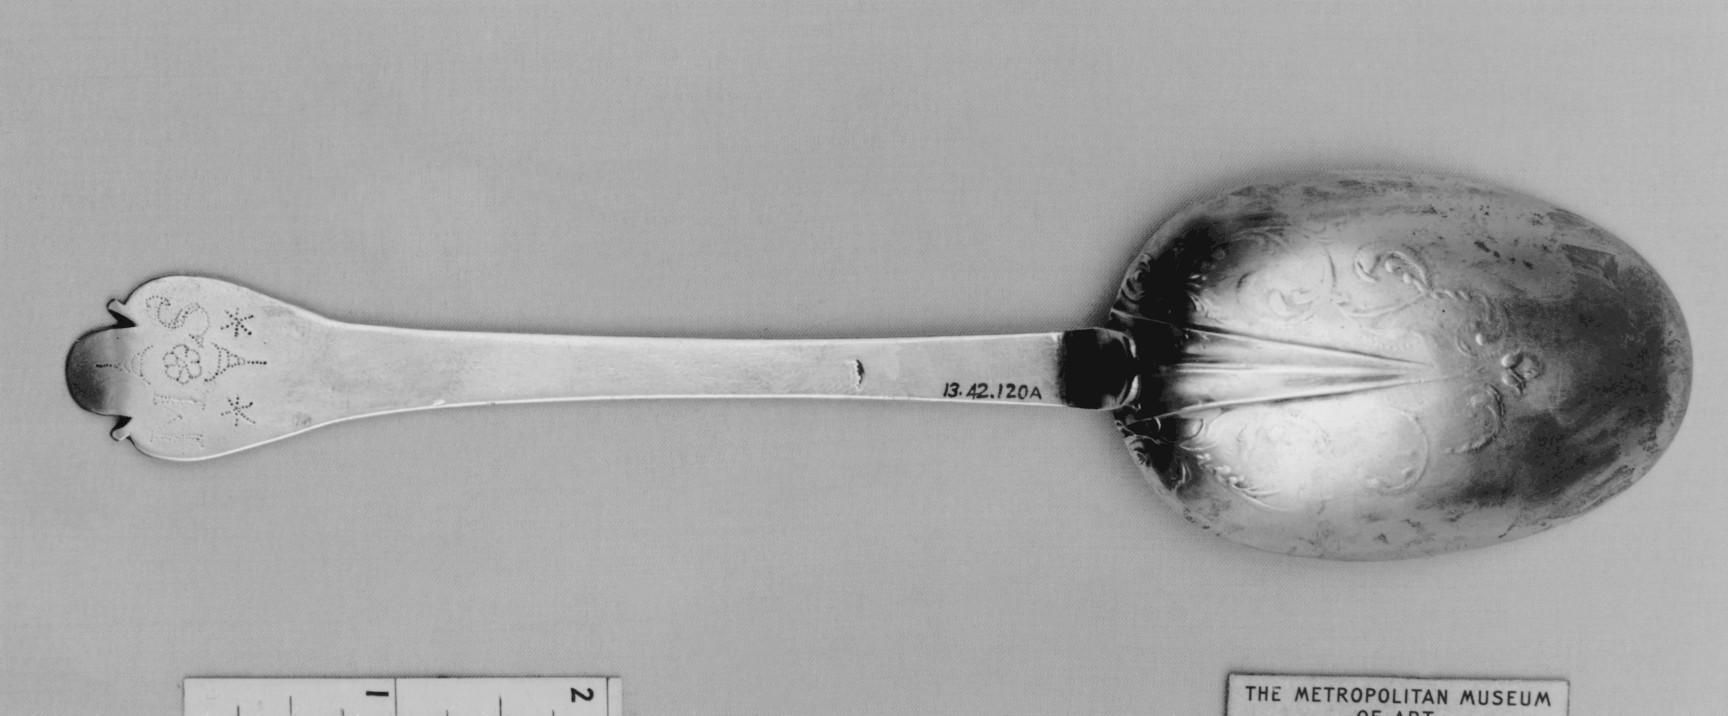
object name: spoon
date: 1685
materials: silver